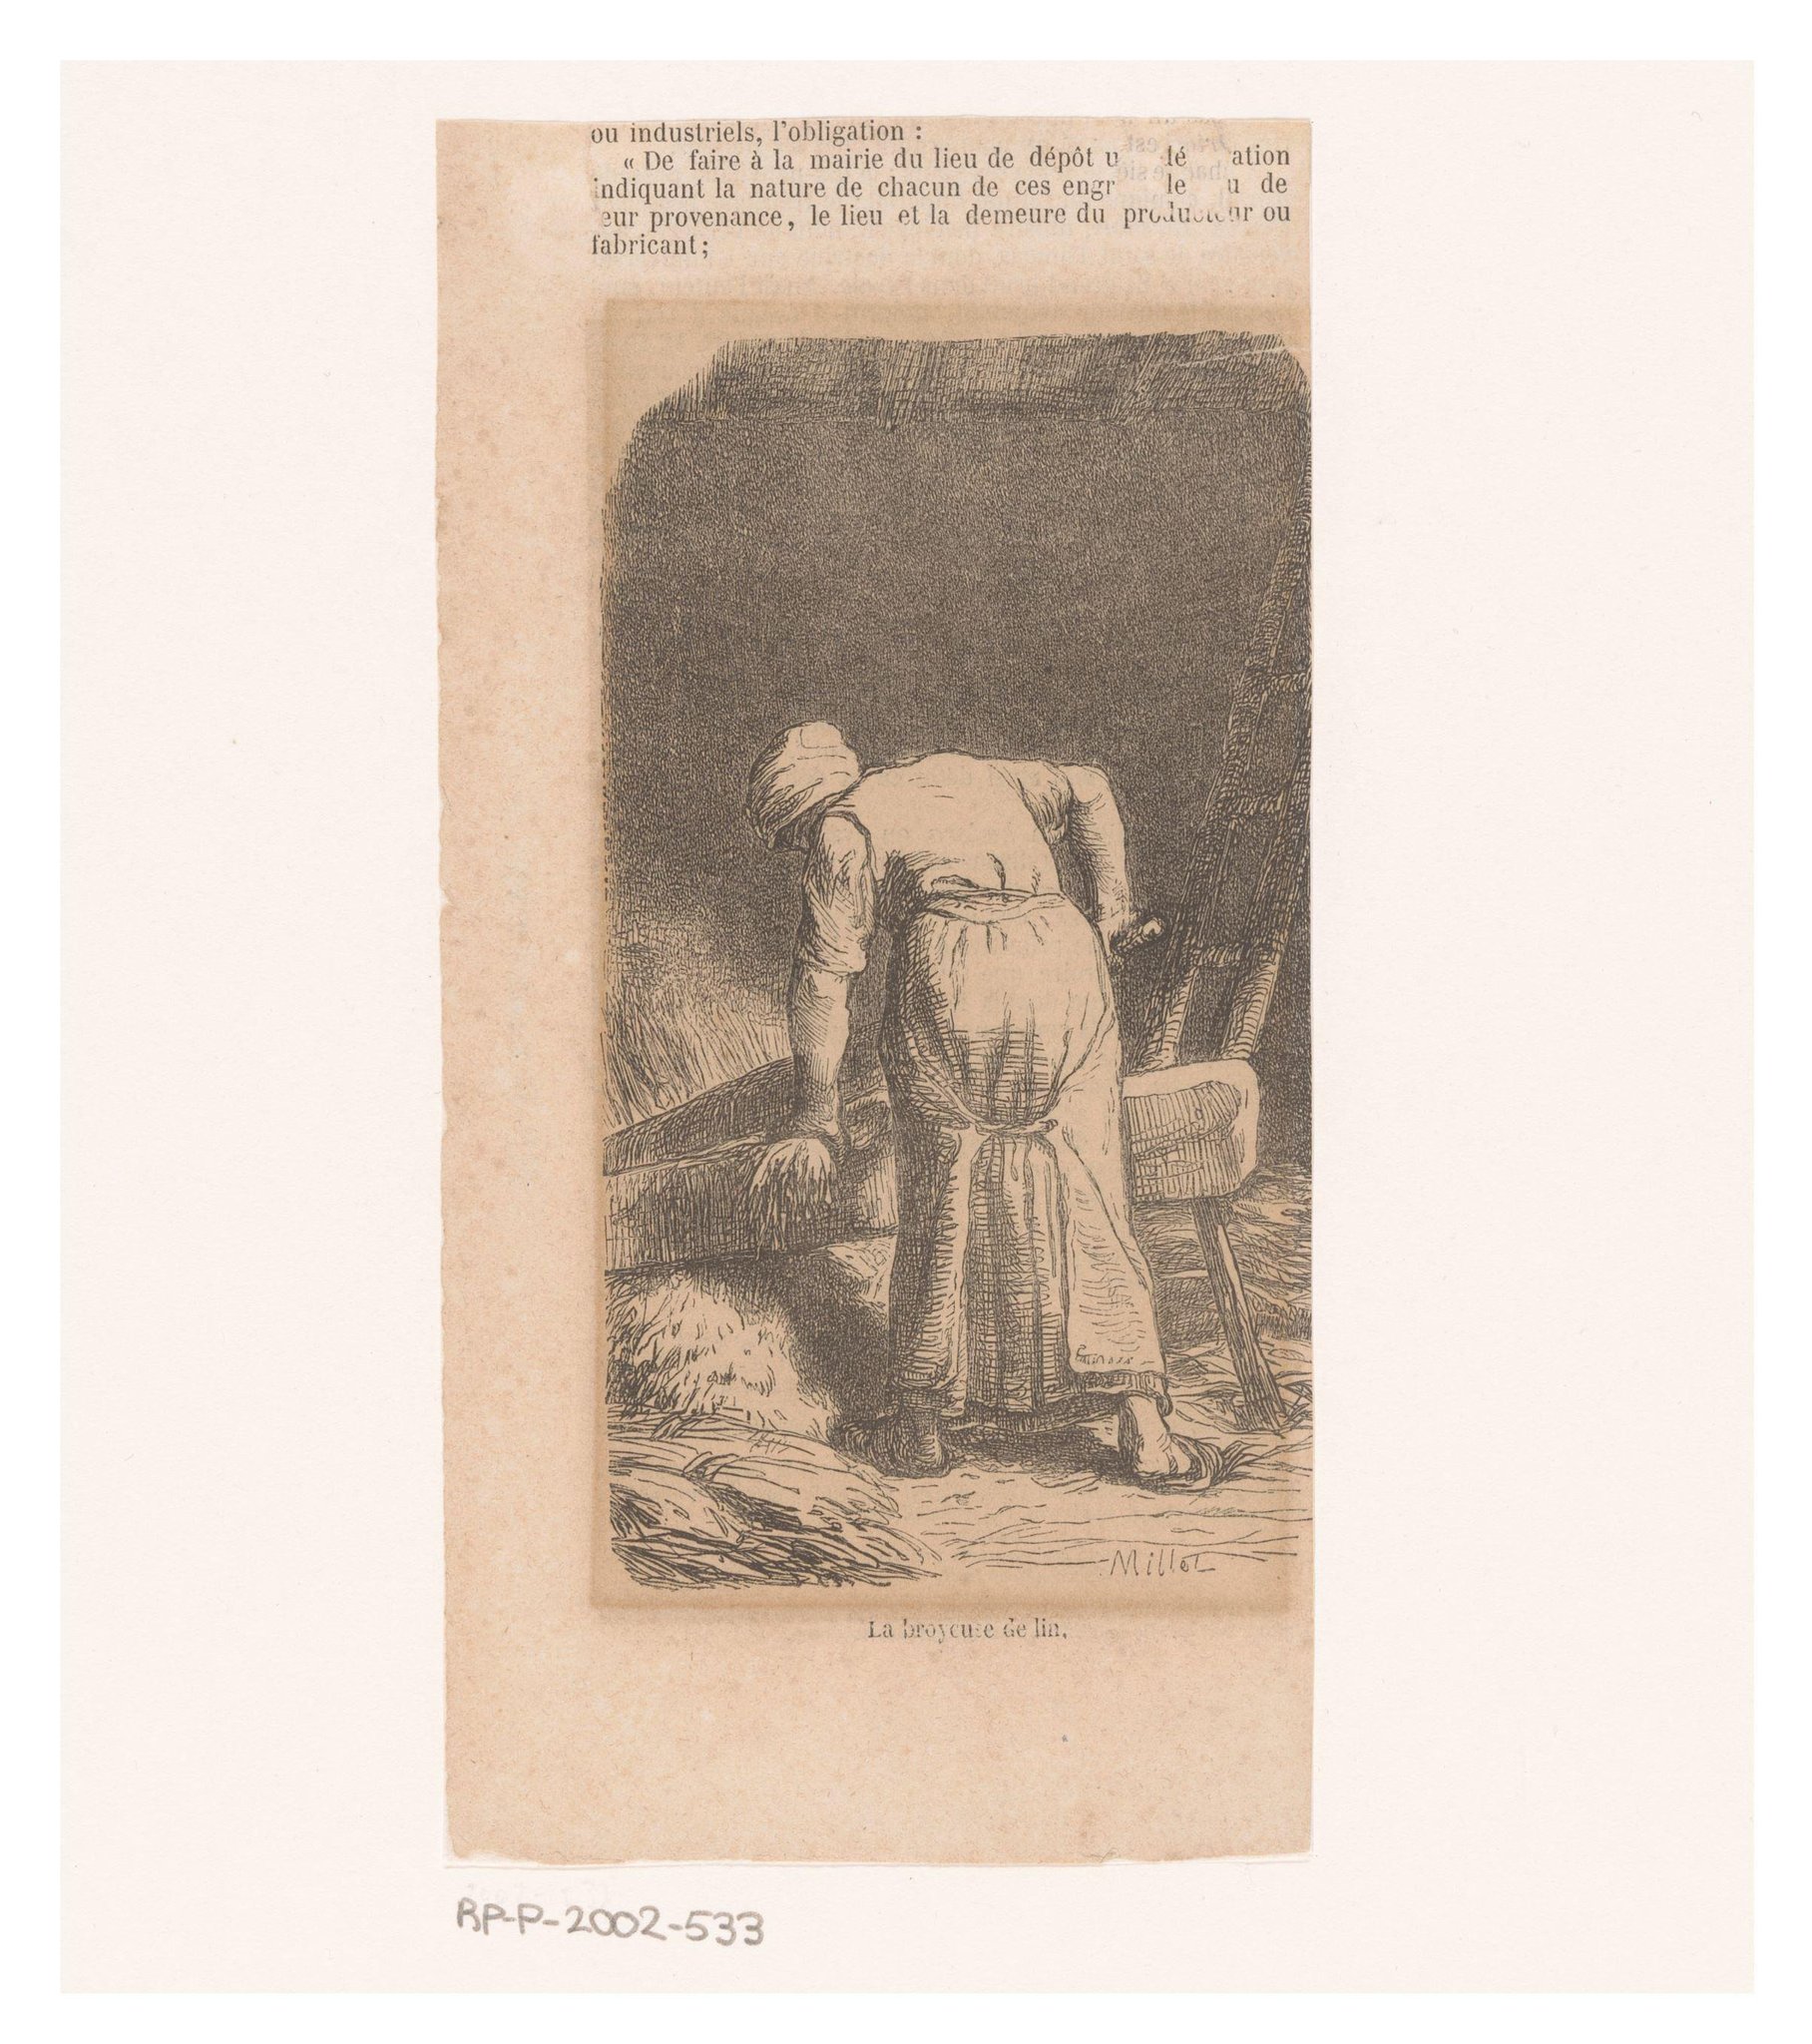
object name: print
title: La broyeuse de lin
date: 1853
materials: paper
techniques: letterpress printing, engraving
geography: paris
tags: flax (material ~ textile industry) (+ labourers ~ crafts, industries, agriculture), crafts and industries (+ agricultural processes)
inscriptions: collector's mark: Lugt 2228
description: Prent maakt deel uit van een serie van tien houtgravures gepubliceerd in 'L'Illustration' van 5 februari 1853, bij het artikel Revue Agricole van Saint-Germain Leduc.